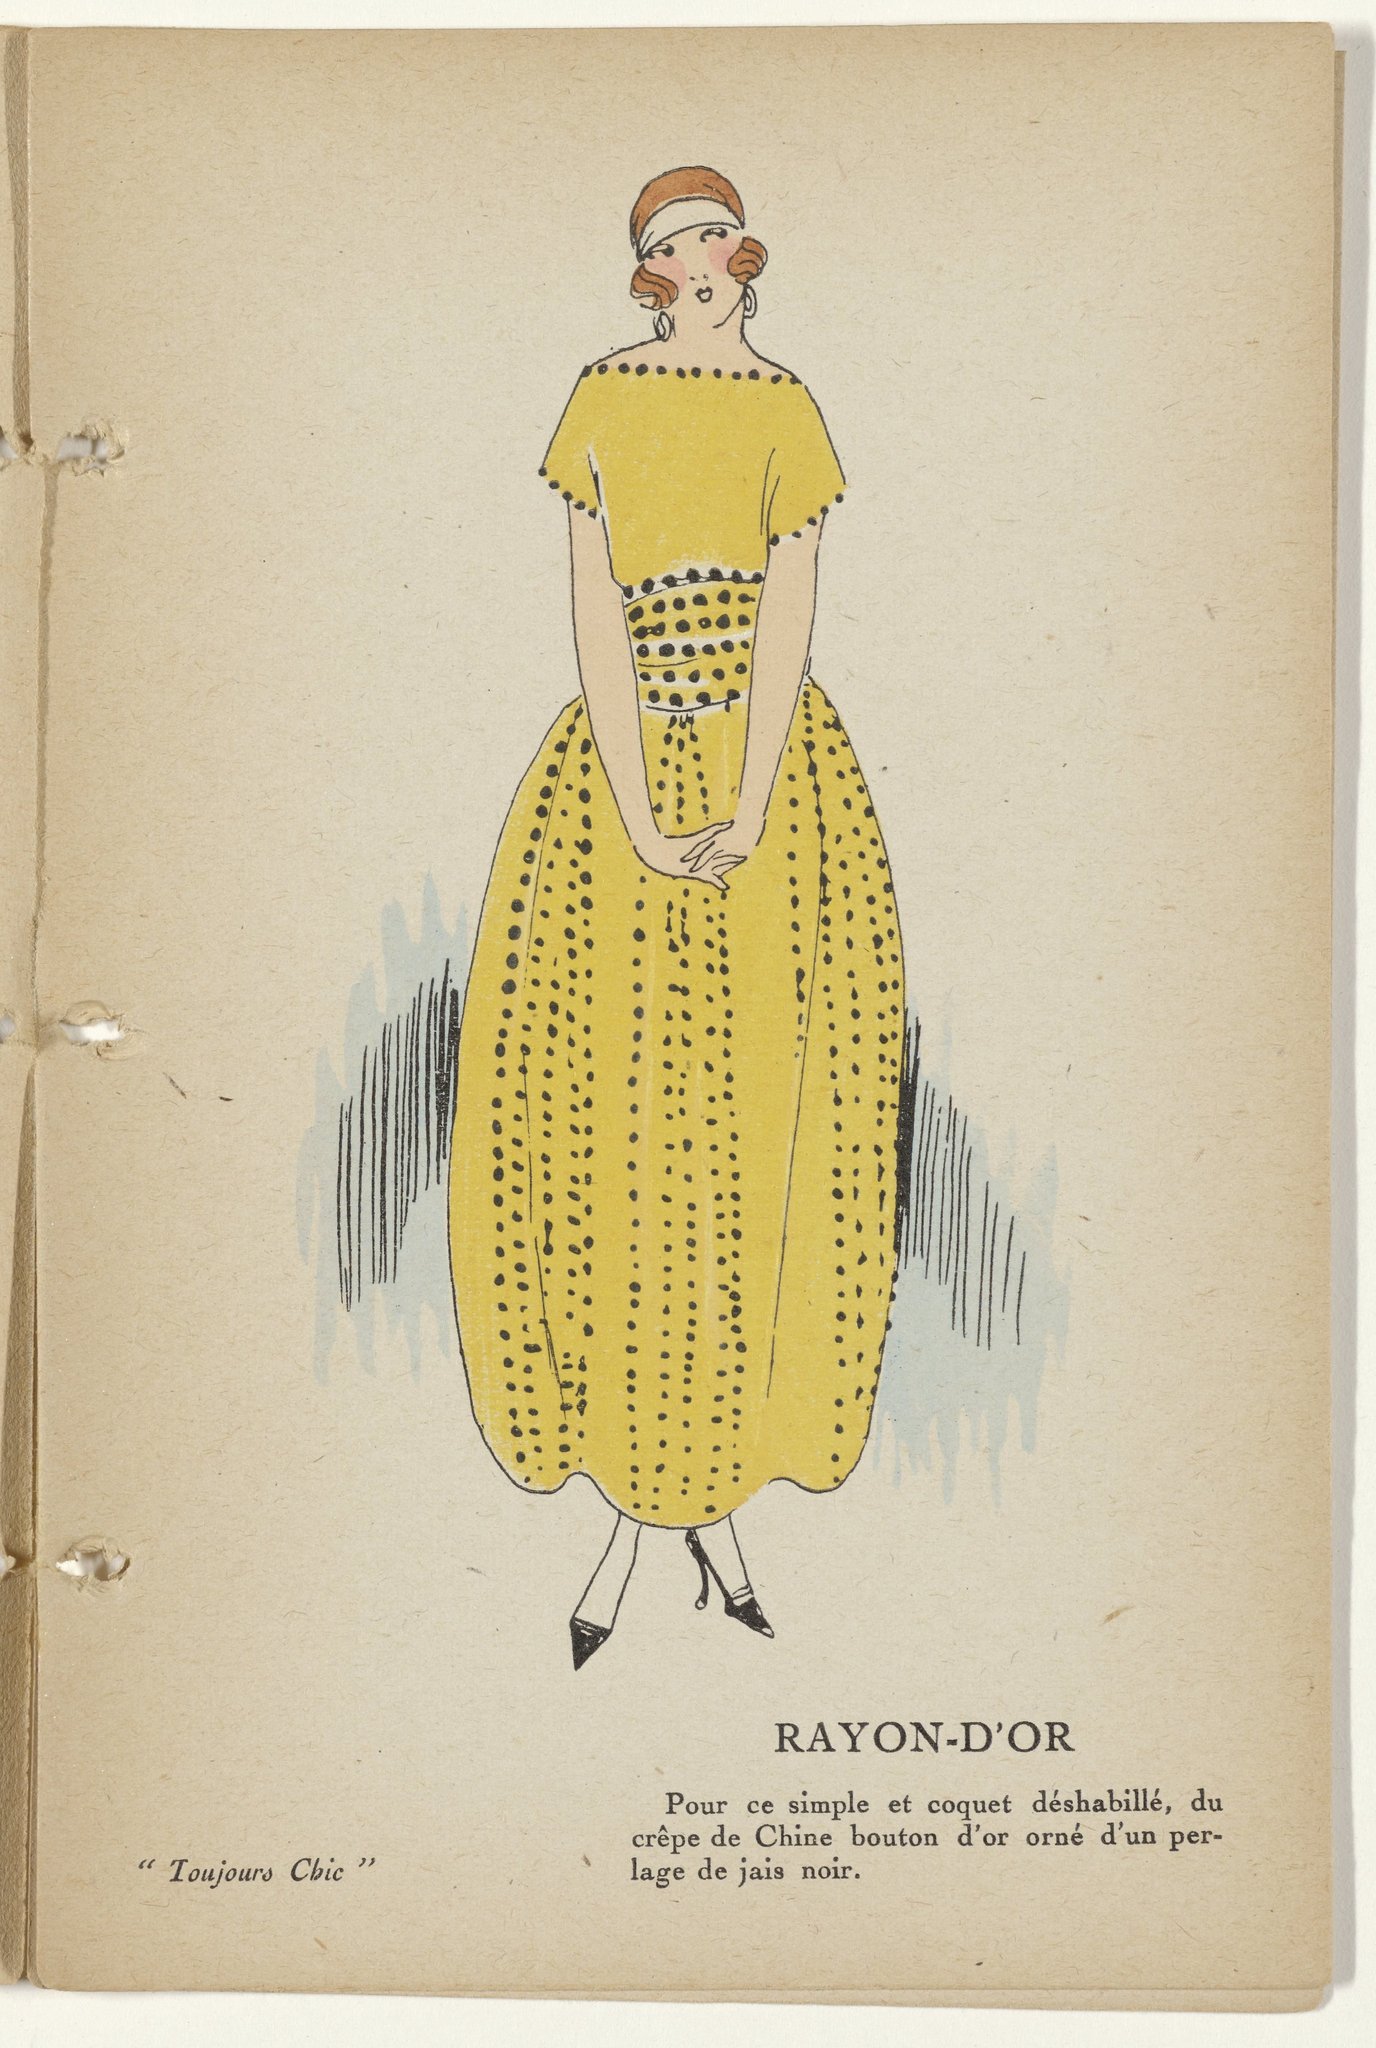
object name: fashion print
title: Toujours Chic Les Deshabillés, Hiver 1921-1922: Rayon-d'or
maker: g-p. joumard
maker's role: publisher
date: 1921-1922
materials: paper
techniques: letterpress printing, pochoir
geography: paris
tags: fashion plates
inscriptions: date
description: Prent uit Catalogus "Toujours Chic" waarin een overzicht van de wintermode 1921-1922.